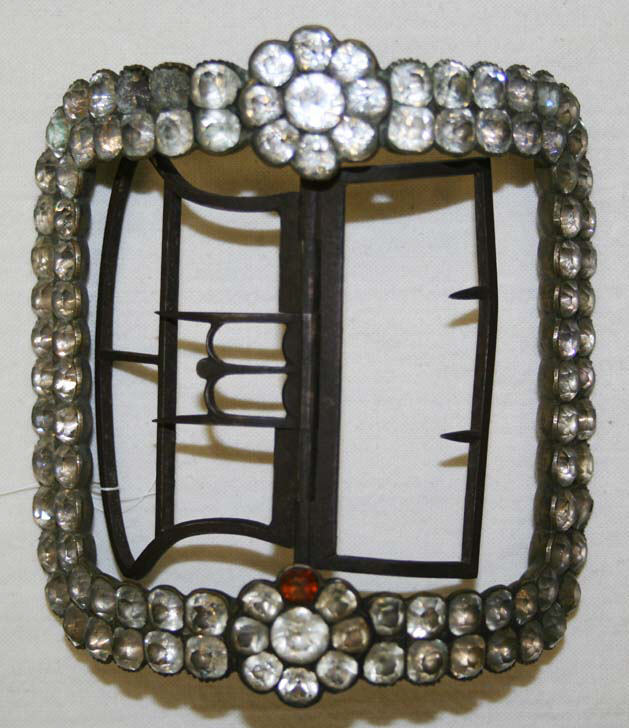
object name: shoe buckle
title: Shoe buckles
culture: british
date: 1767-1800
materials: metal, paste